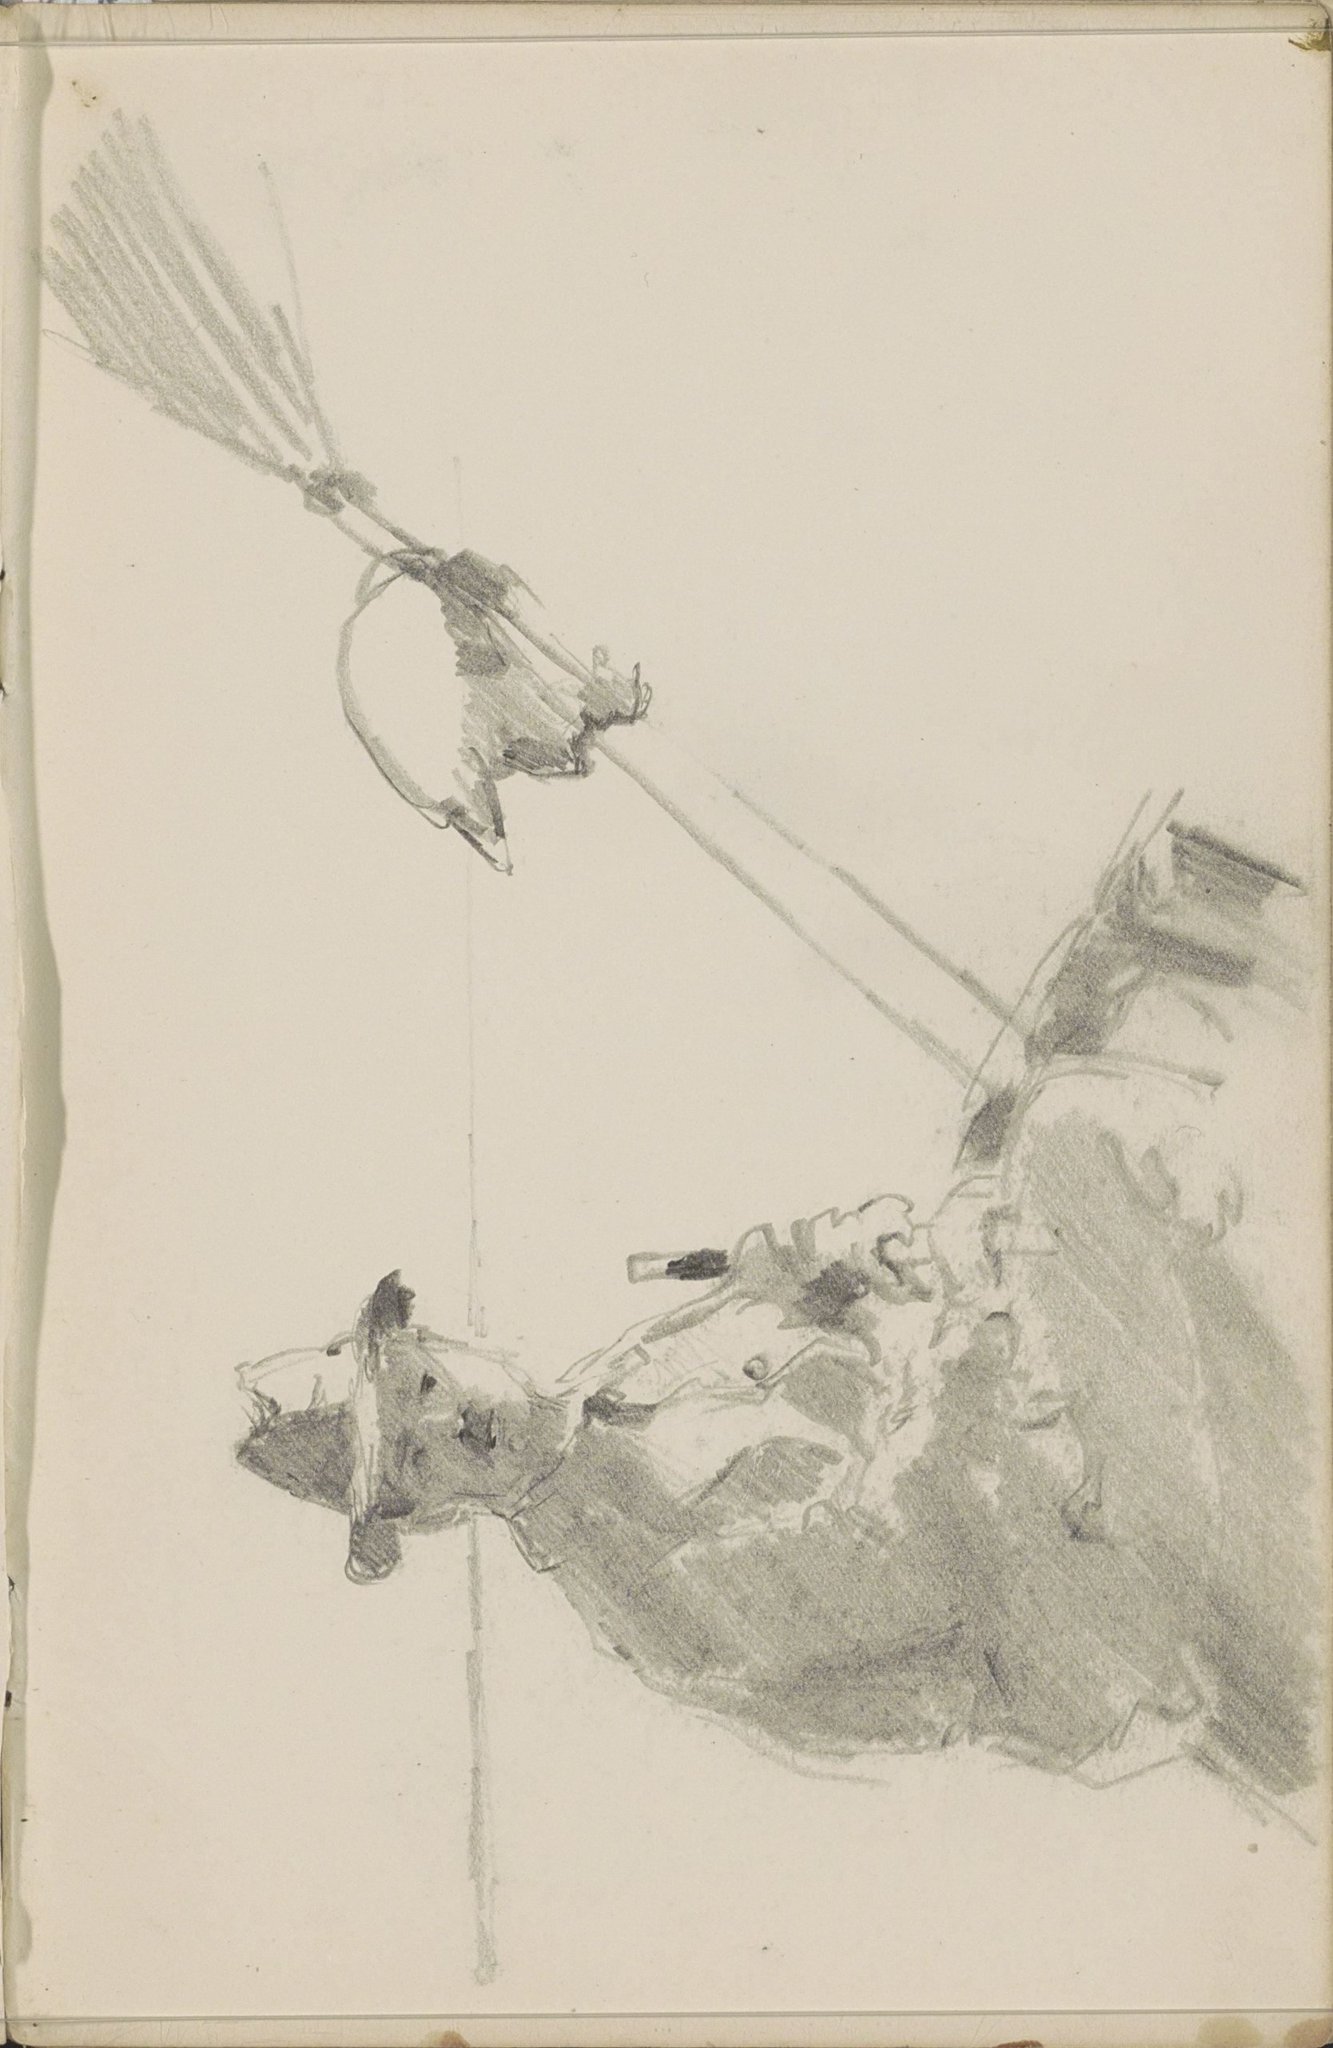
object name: sketchbook leaf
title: Zittende man in een boot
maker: cornelis vreedenburgh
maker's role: draughtsman, print maker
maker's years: 1880-1946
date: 1890-1946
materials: paper, pencil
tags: sitting figure, rowing-boat, canoe, etc.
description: De man draagt een pak en hoed. Mogelijk een zelfportret van de kunstenaar. Tevens een studie van een kop van een man met een pet. Blad 14 recto uit een schetsboek met 45 bladen.